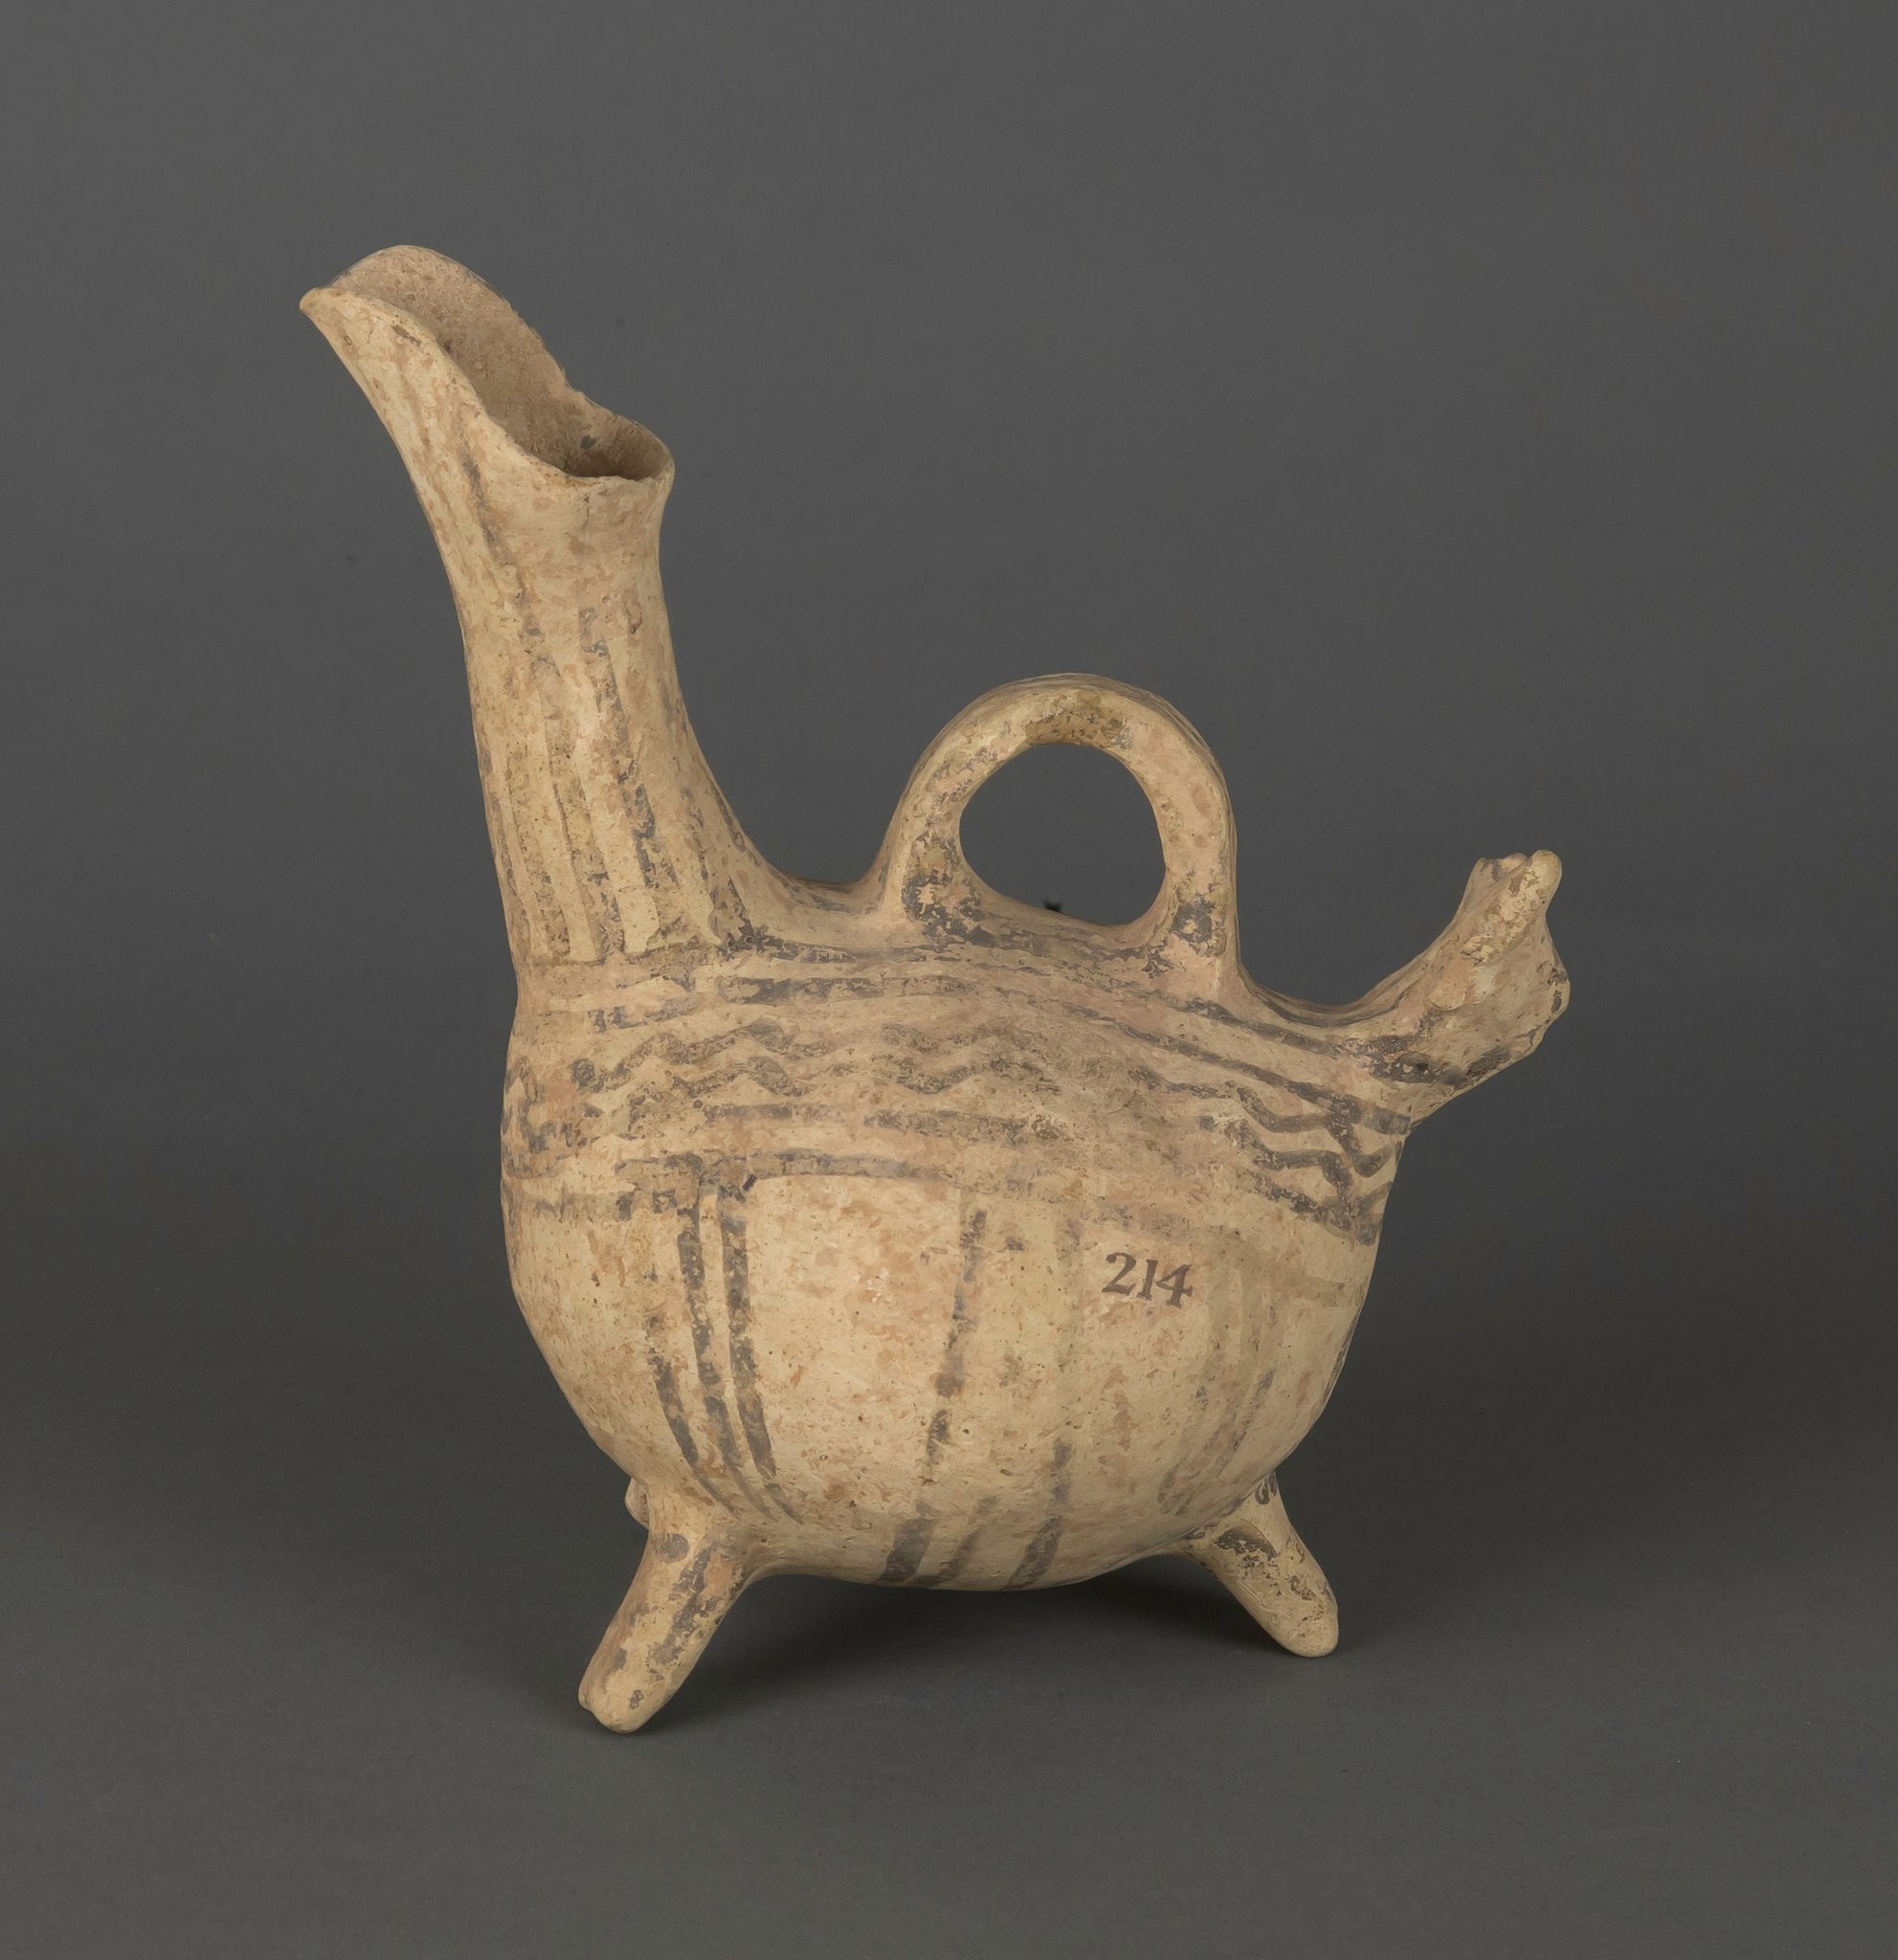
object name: askos in the form of an animal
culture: cypriot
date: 1900-1600 BCE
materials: terracotta